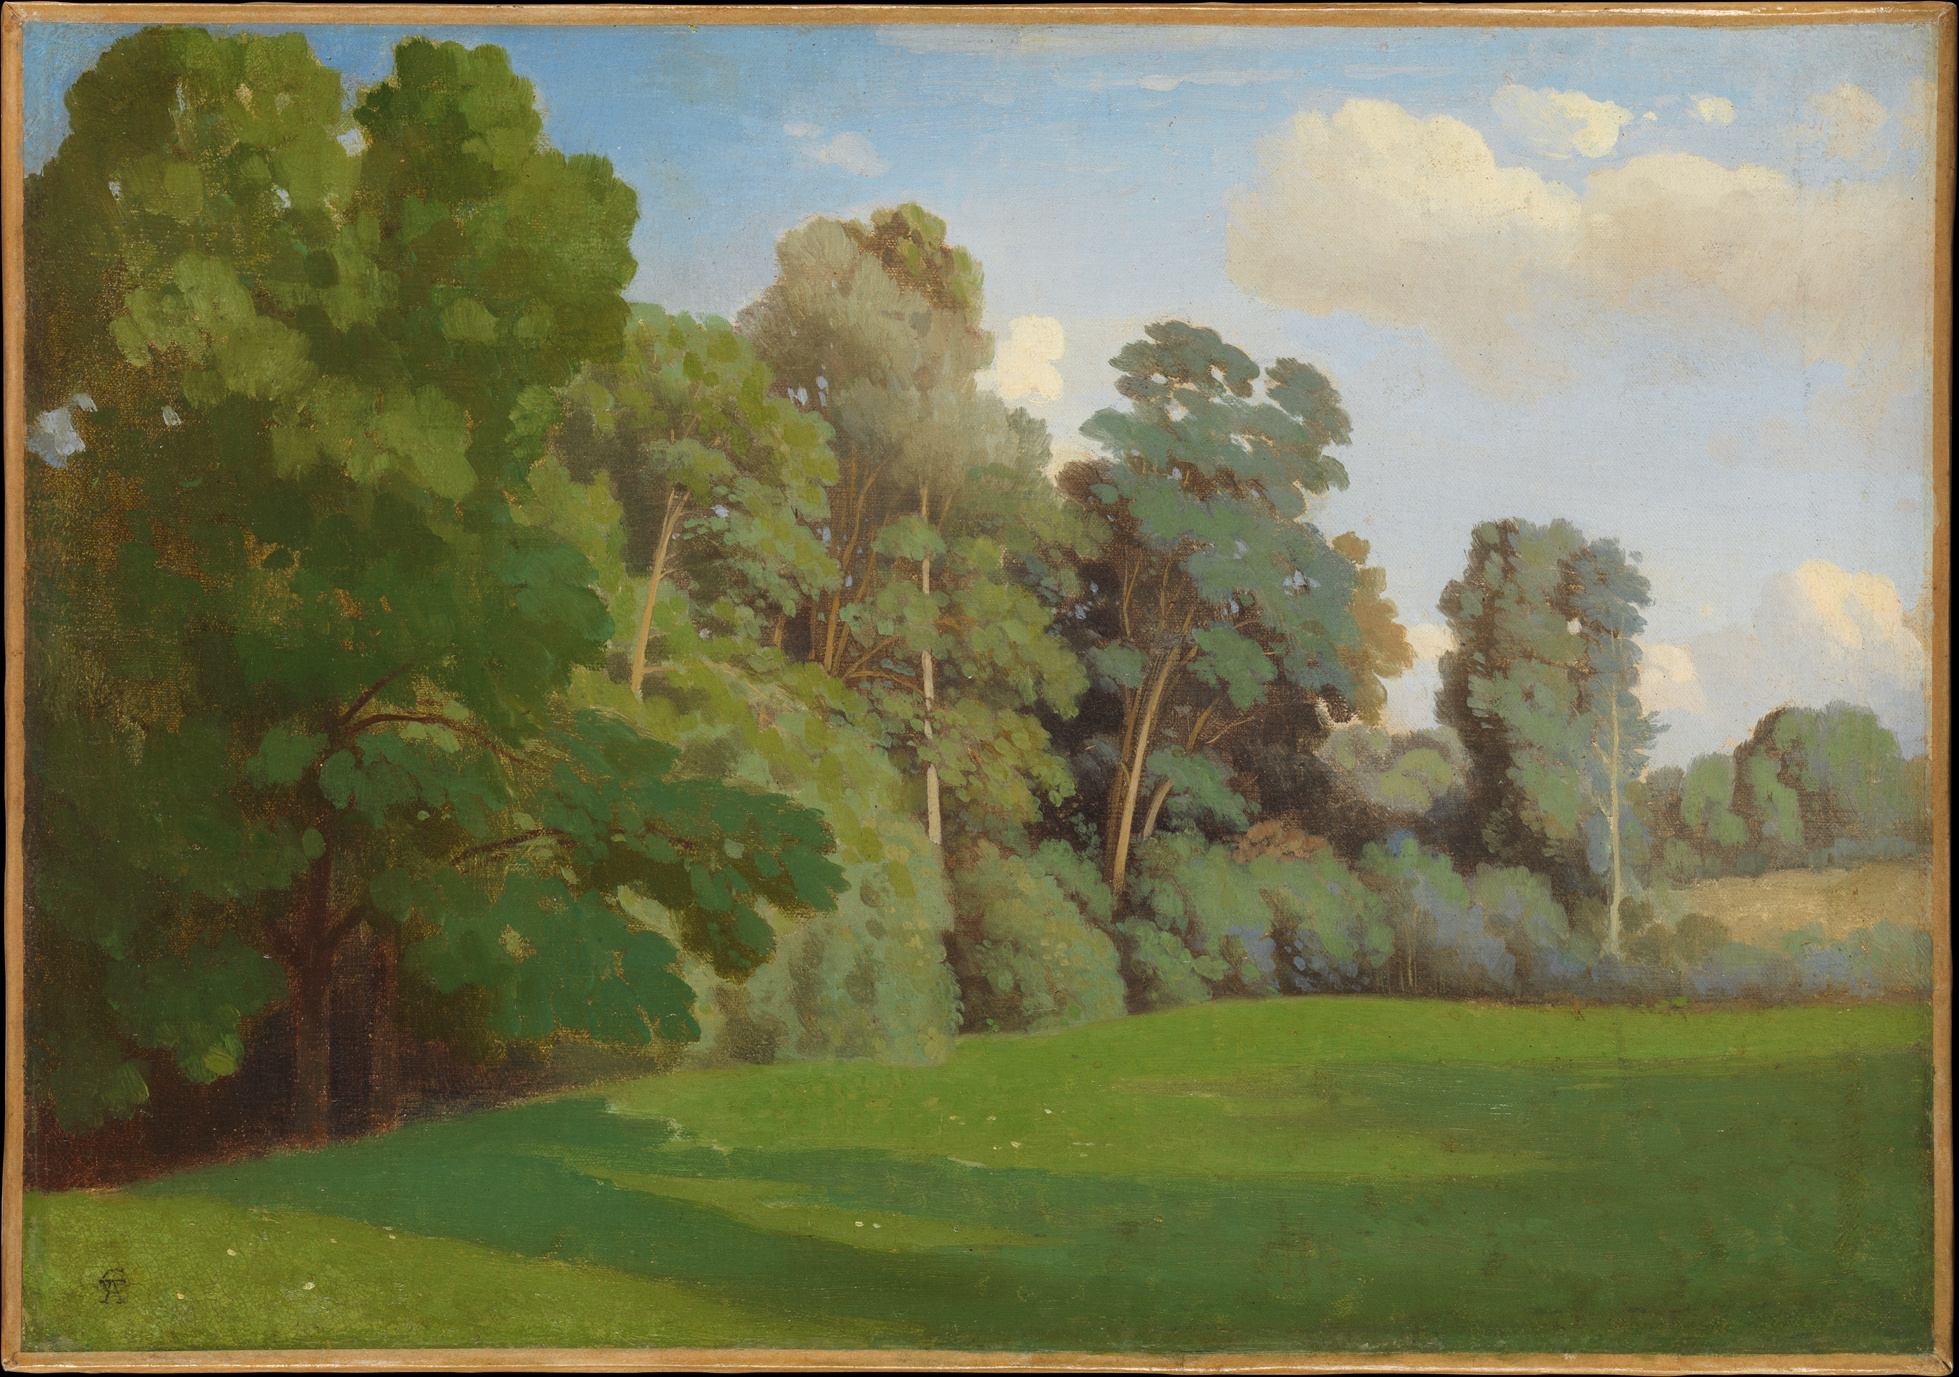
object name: painting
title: Edge of a Wood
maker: théodore caruelle d'aligny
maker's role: artist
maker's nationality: french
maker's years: 1798-1871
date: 1850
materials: canvas, oil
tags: forests,landscapes